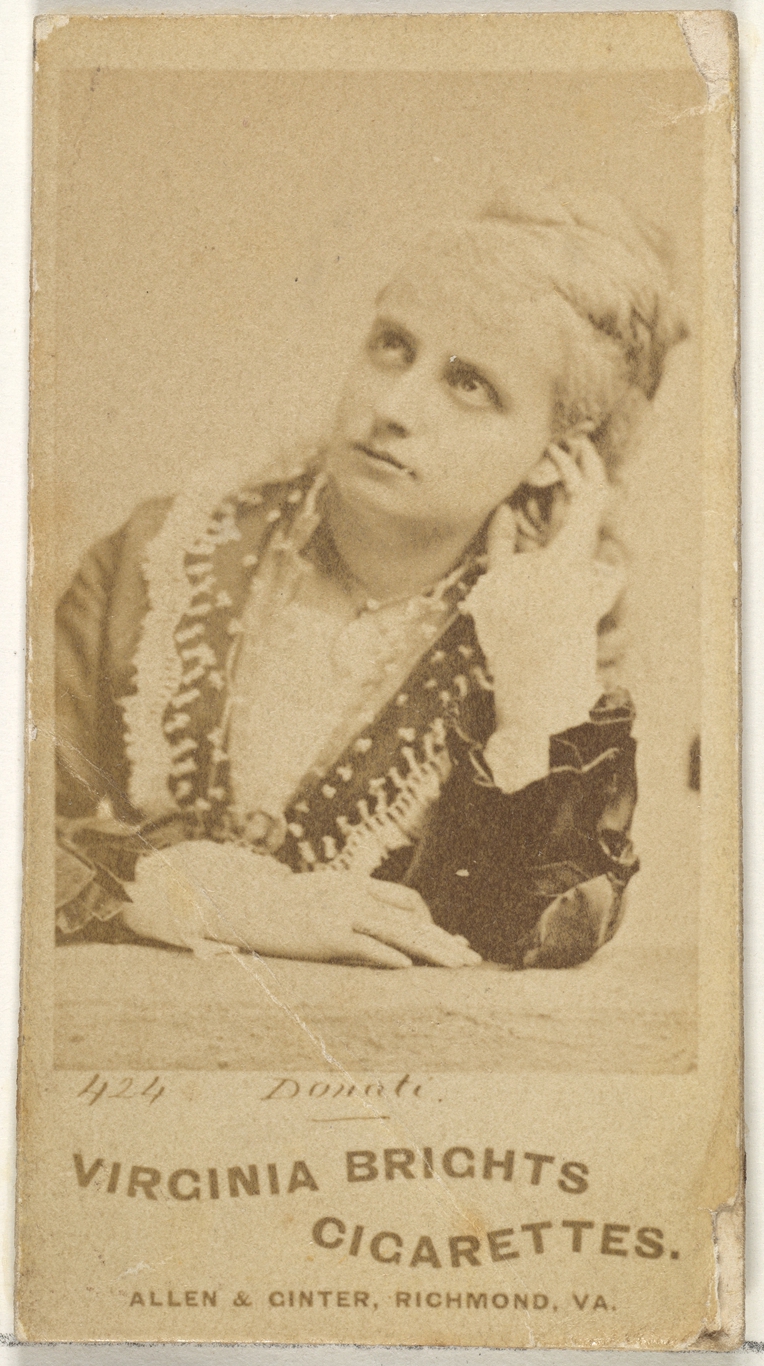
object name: photograph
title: Card 424, Donati, from the Actors and Actresses series (N45, Type 1) for Virginia Brights Cigarettes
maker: allen & ginter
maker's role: publisher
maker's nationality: american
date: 1888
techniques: albumen silver print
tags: portraits,women,actresses